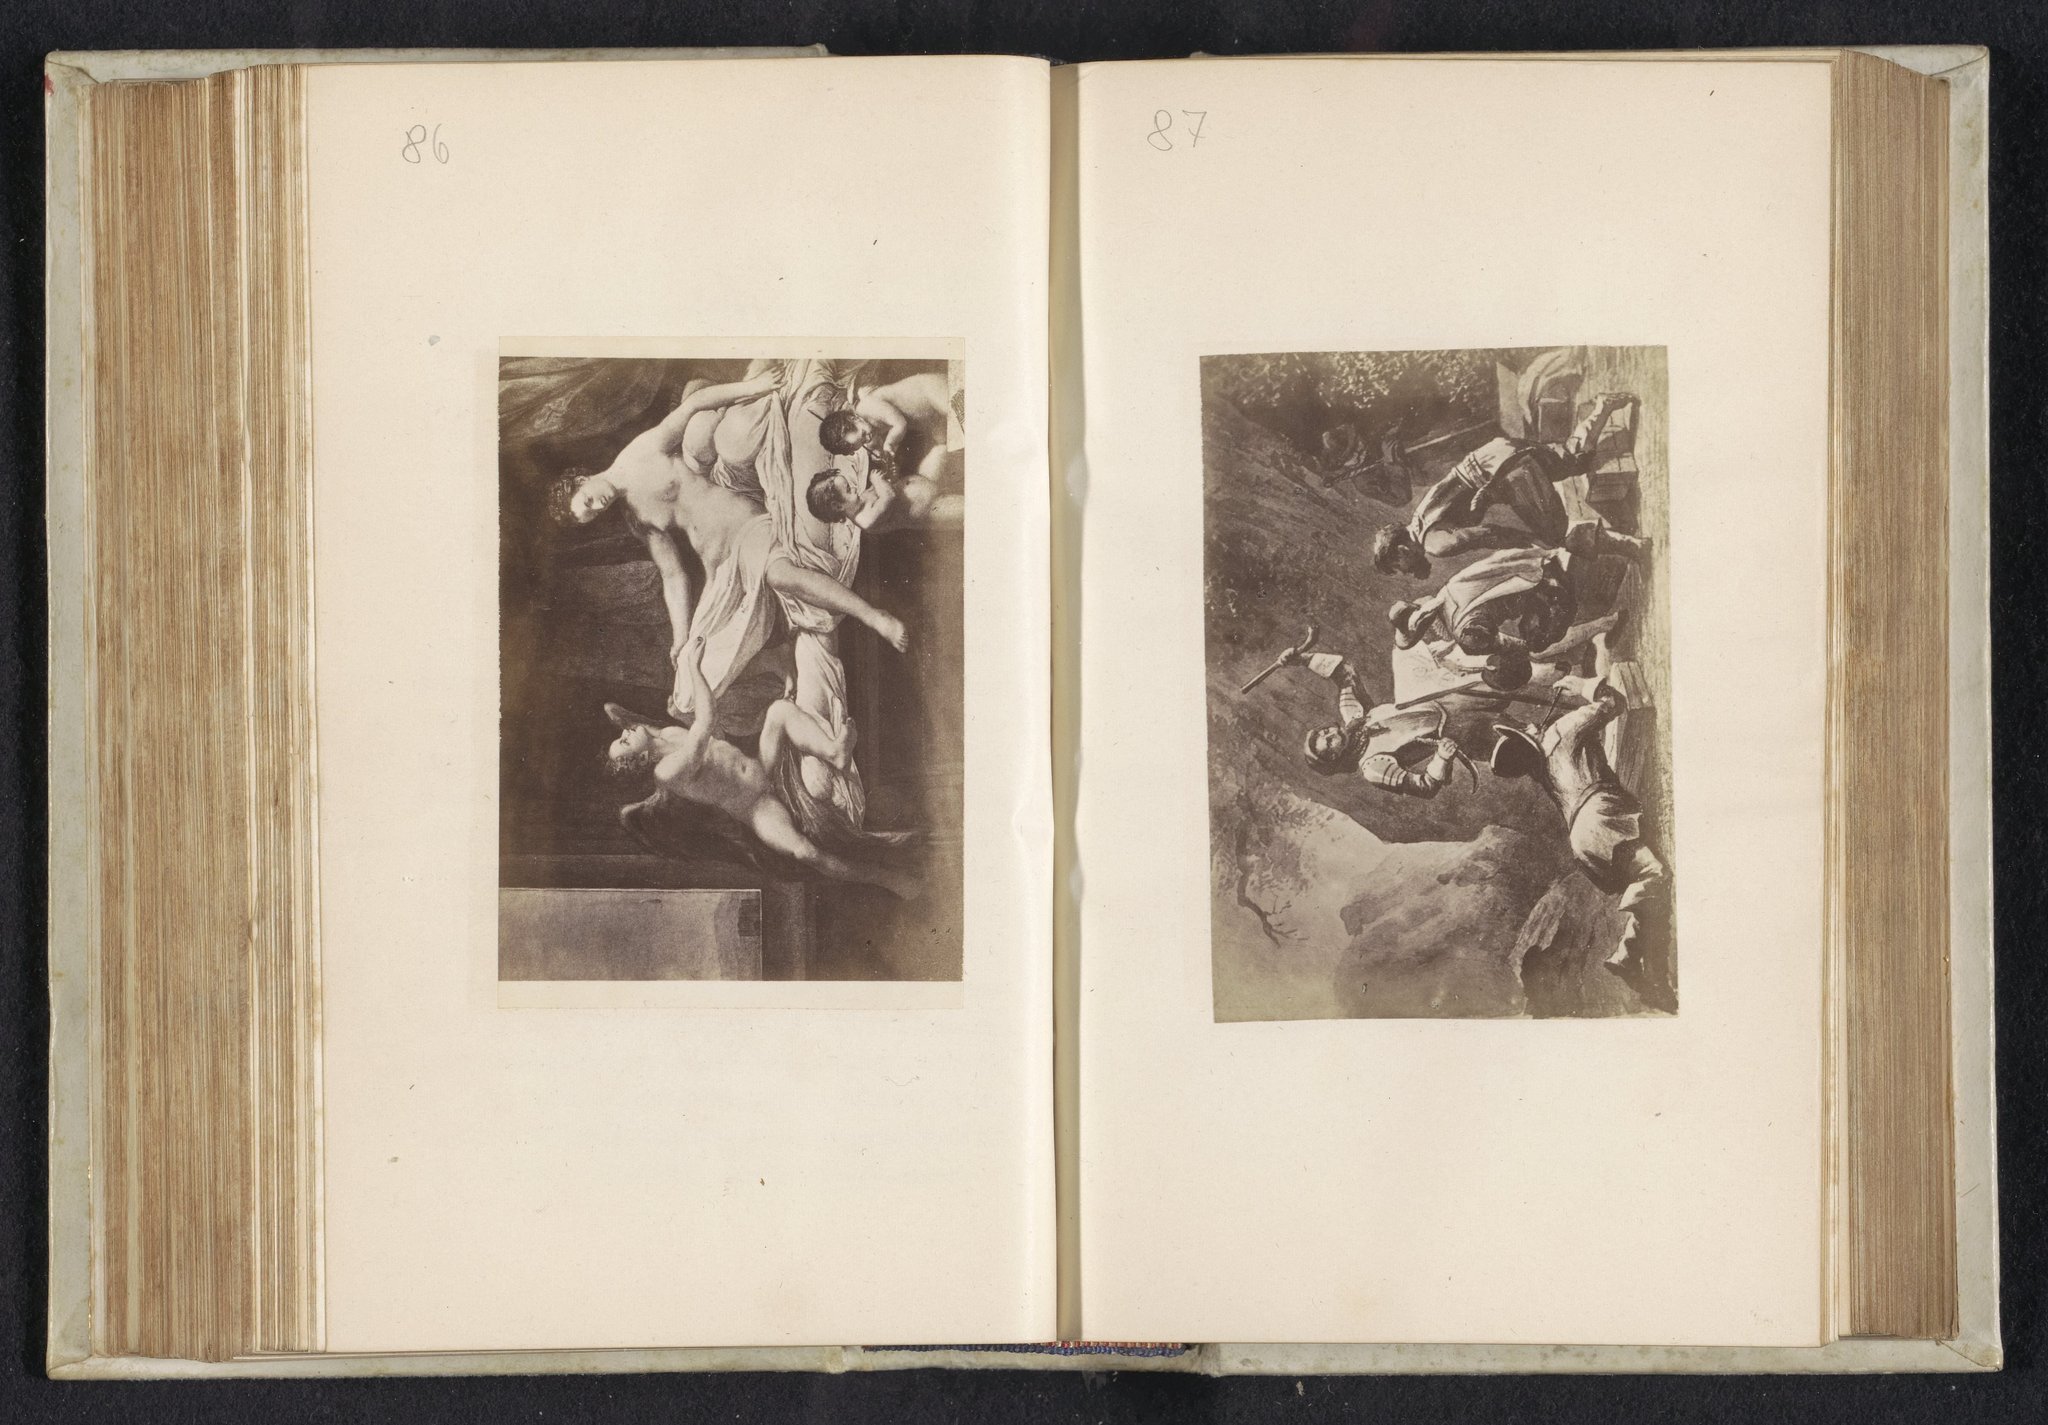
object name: photograph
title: Fotoreproductie van een schilderij, voorstellende drie mannen tekenen een man na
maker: Anonymous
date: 1850-1860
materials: photographic support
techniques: albumen print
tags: drawing, adult man